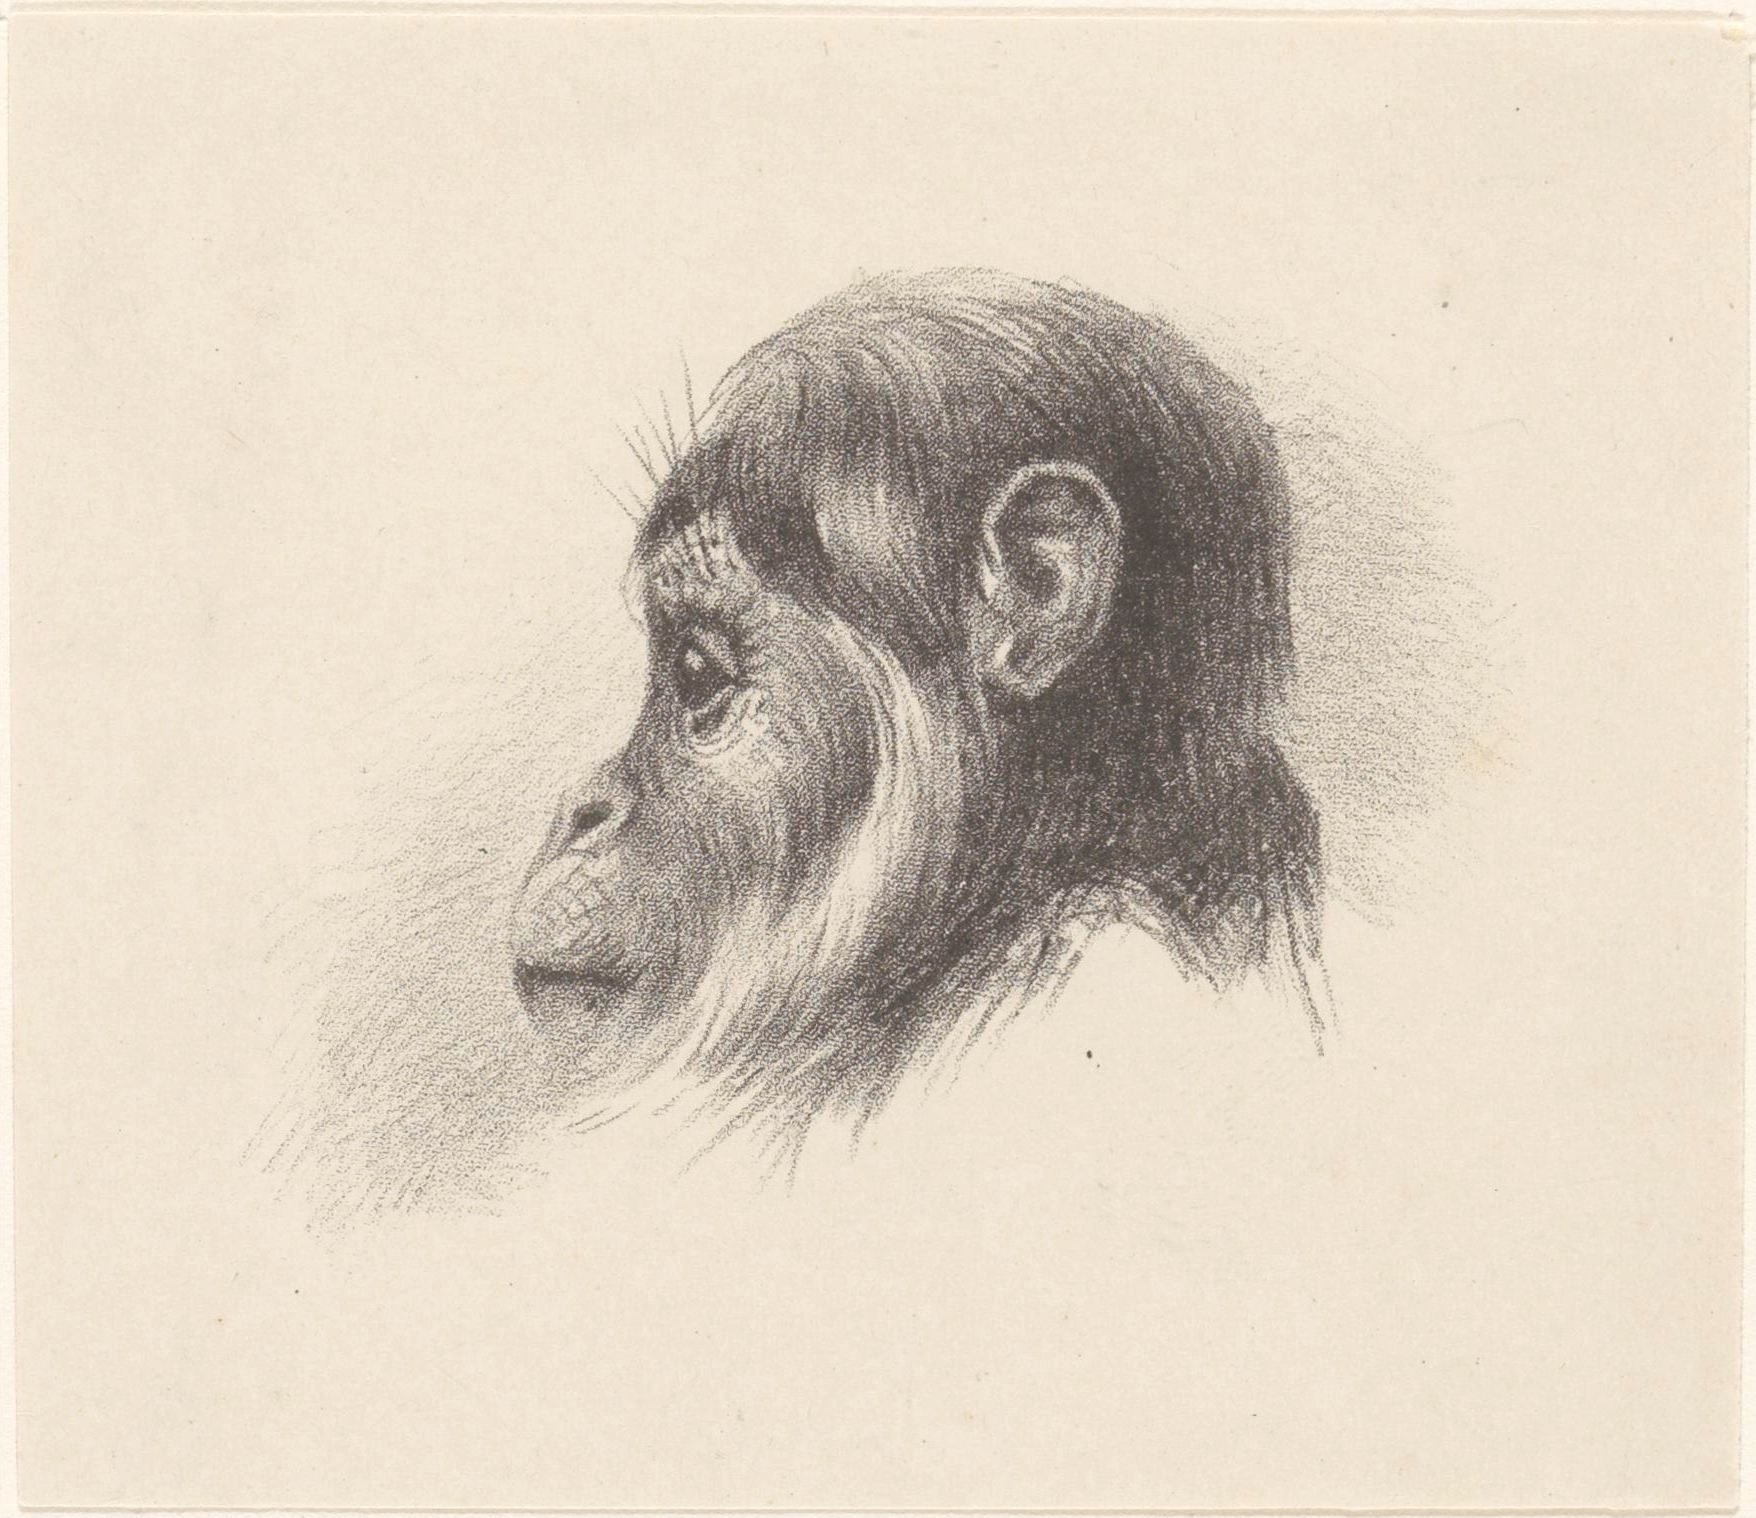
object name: print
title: Apenkop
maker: theo van hoytema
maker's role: draughtsman, painter, print maker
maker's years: 1863-1917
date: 1878-1890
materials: paper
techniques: lithograph, lithography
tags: monkeys, apes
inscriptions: collector's mark: Lugt 2228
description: Prent gebruikt voor de omslag van: Büttikofer, J. Reisebilder aus Liberia. Resultate geographischer, naturwissenschaftlicher und ethnographischer Untersuchungen während der Jahre 1879-1882 und 1886-1887. Leiden: 1890. Voor details over de gebruikte techniek, zie: De Groot, Irene Margaretha. De grafiek van Theo van Hoytema, 1863-1917. Amsterdam: 1977 (cat. Rijksmuseum Amsterdam), p. 13.